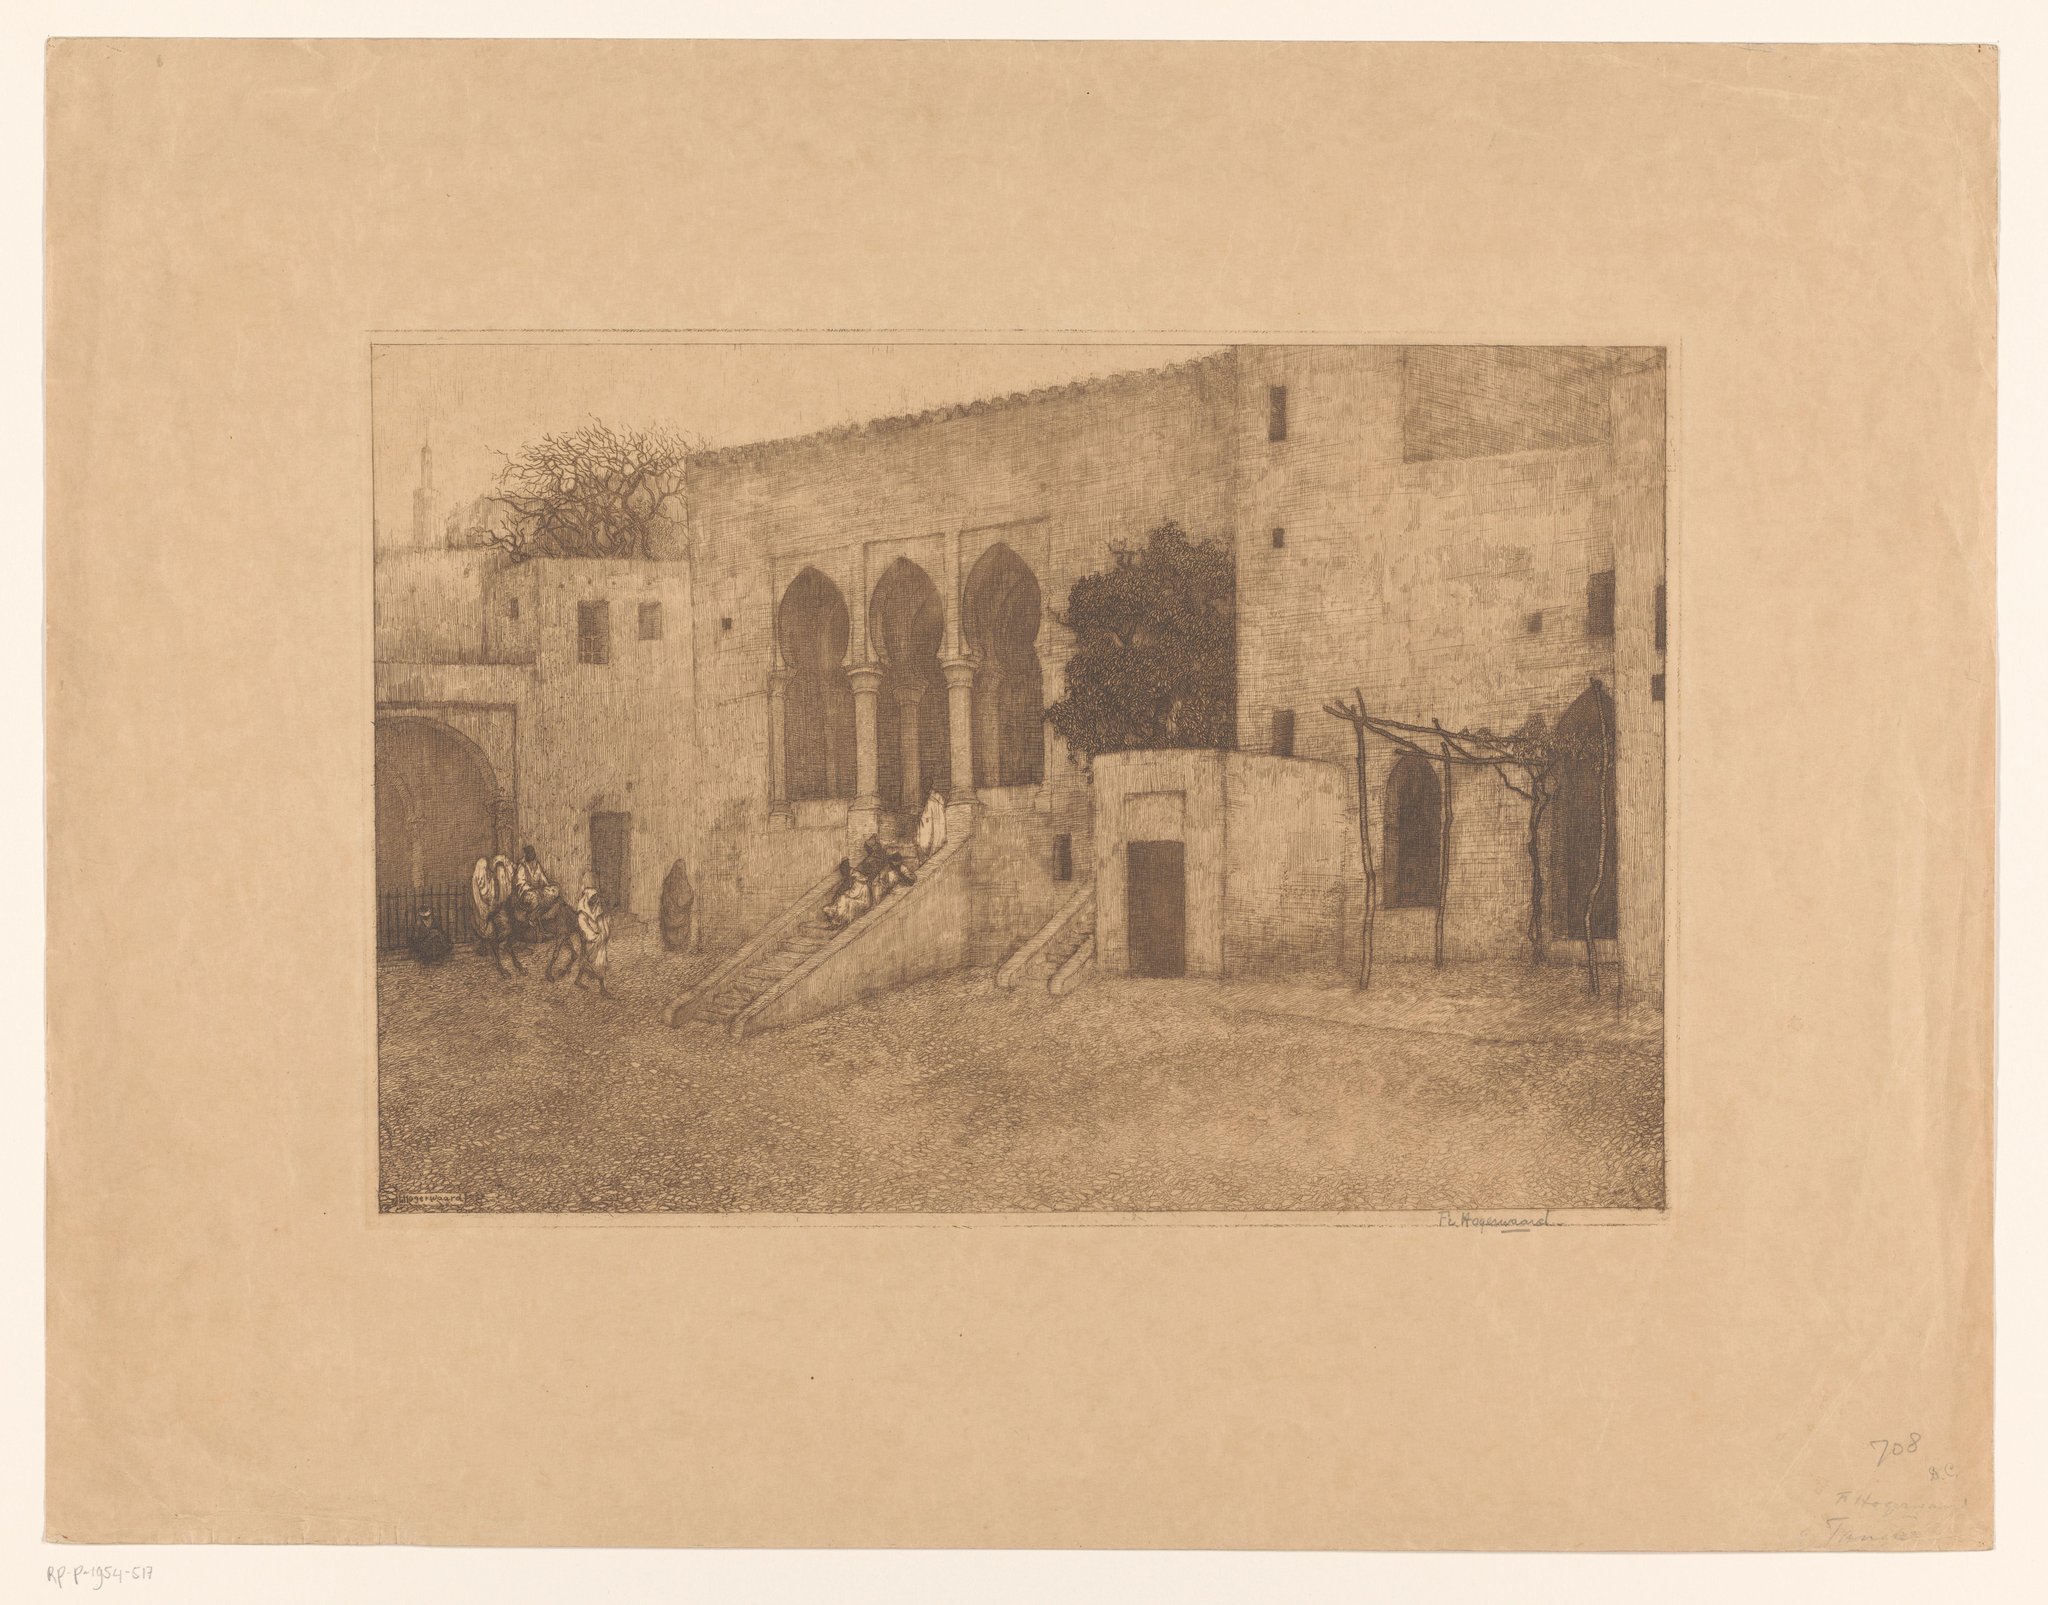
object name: print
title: Oosters paleis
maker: frans hogerwaard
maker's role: print maker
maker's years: 1882-1921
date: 1892-1921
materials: paper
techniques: etching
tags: palace, village square, place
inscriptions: collector's mark: Lugt 2228